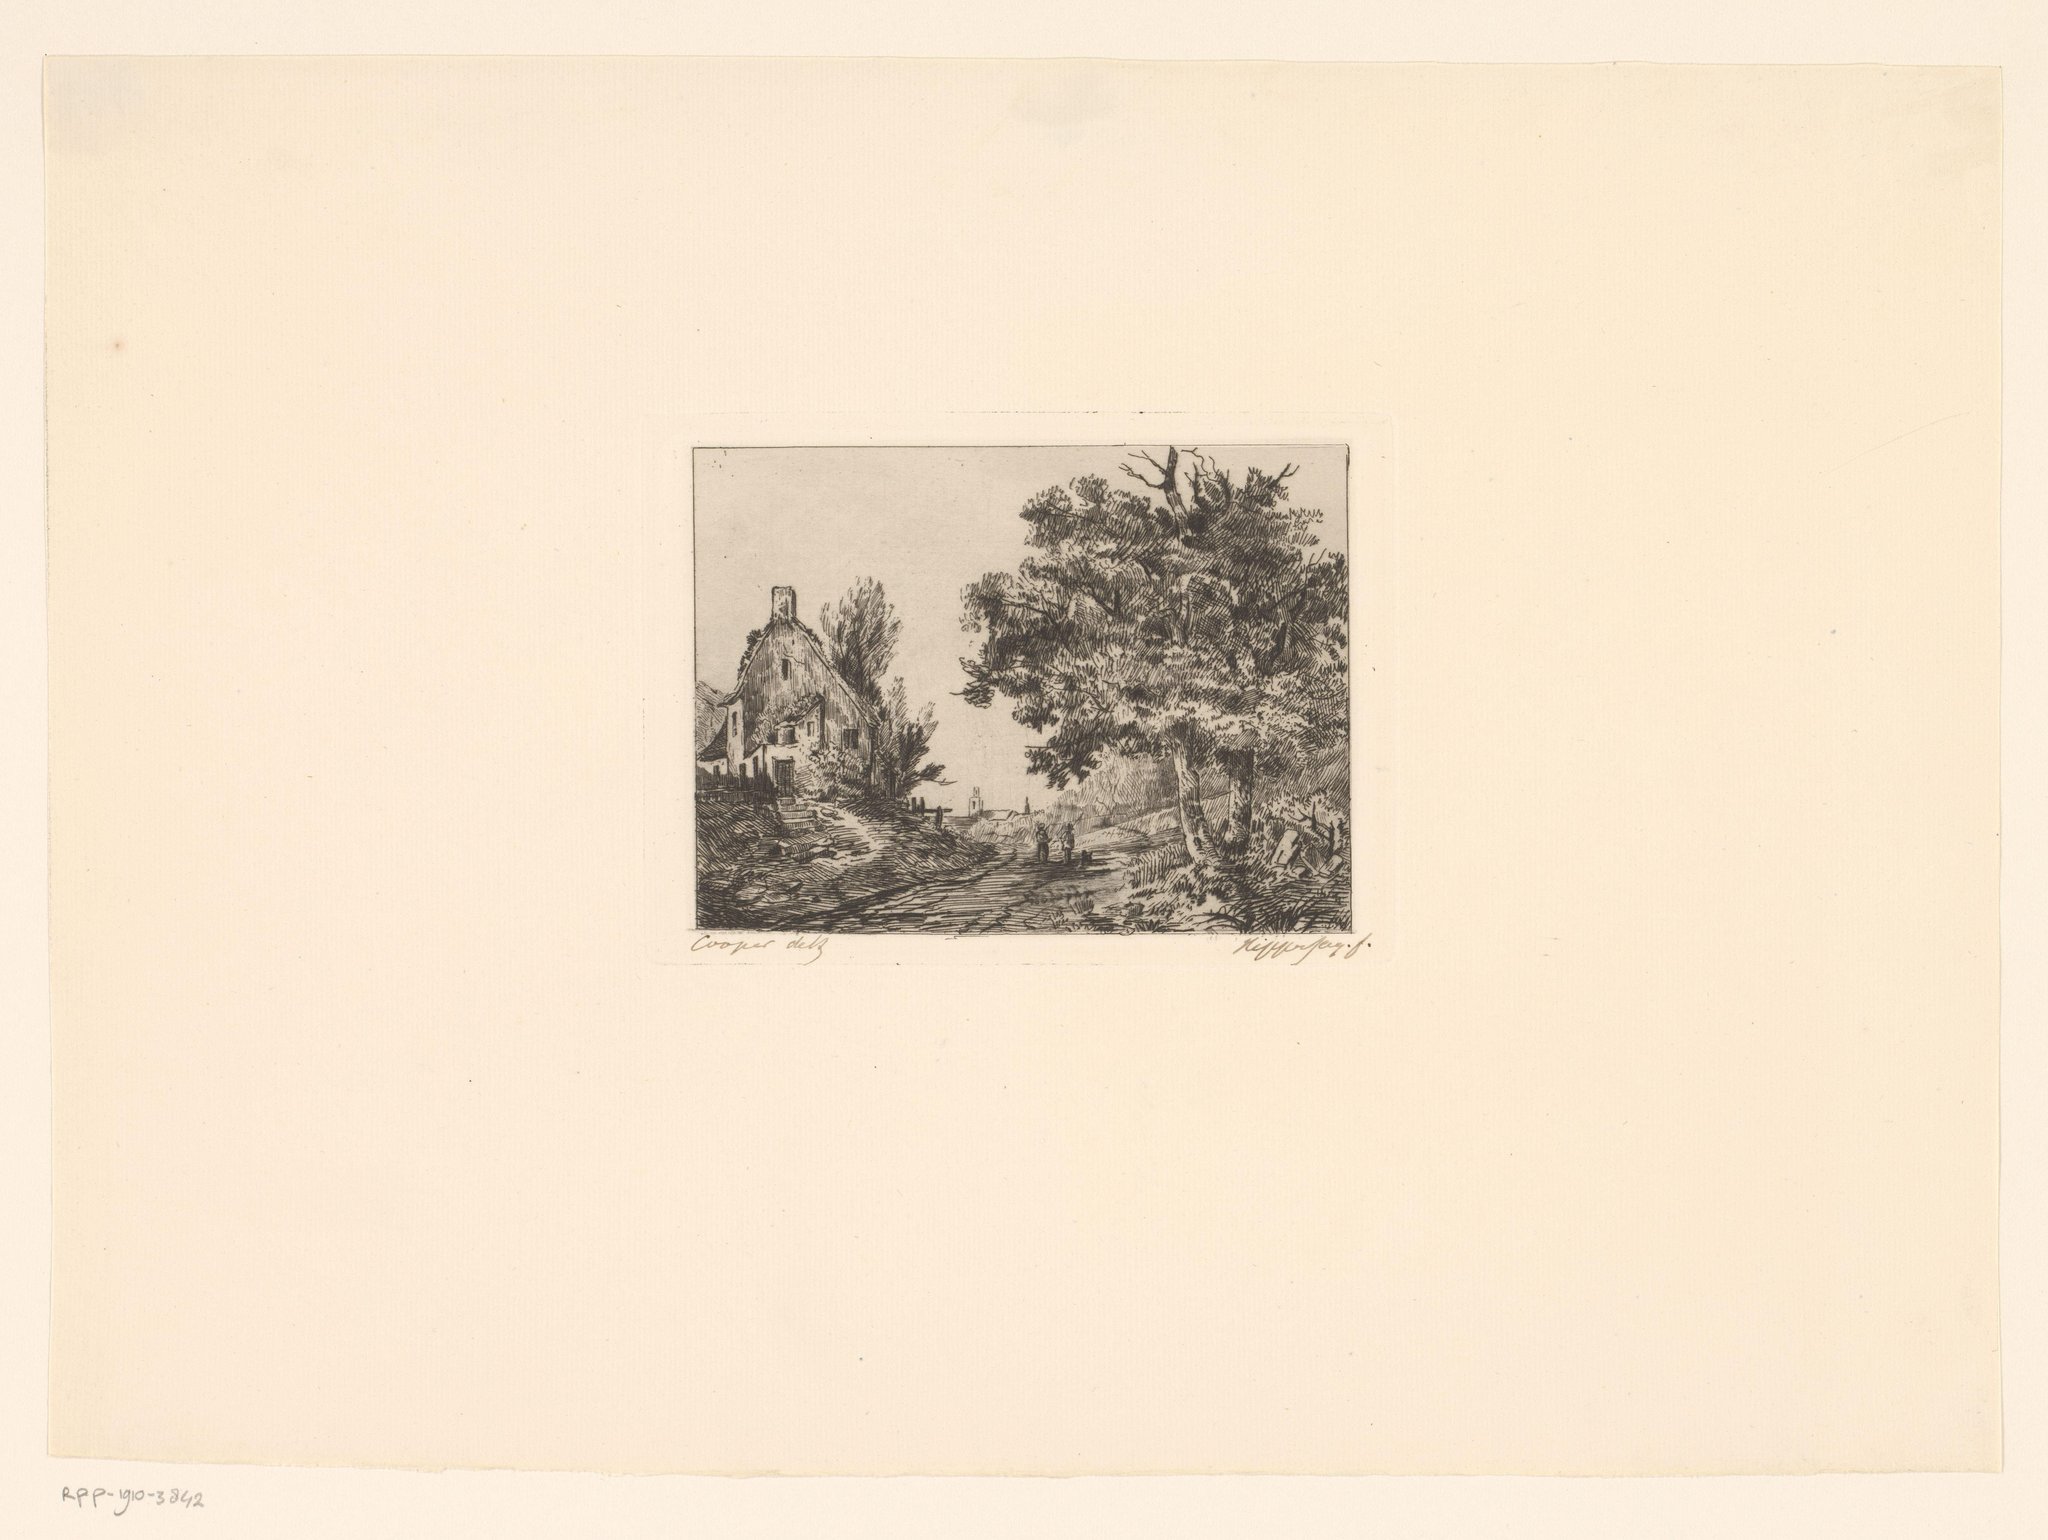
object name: print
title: Landschap met links een huis en rechts een boom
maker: karel theodoor hippert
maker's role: print maker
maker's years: 1839-1919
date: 1849-1910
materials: paper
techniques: etching, intaglio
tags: city-view, and landscape with man-made constructions, road, path, civic architecture; edifices; dwellings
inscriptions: mark: ‘Cooper del.’, collector's mark: Lugt 2228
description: Op de landweg tussen het huis en de boom lopen twee figuren.